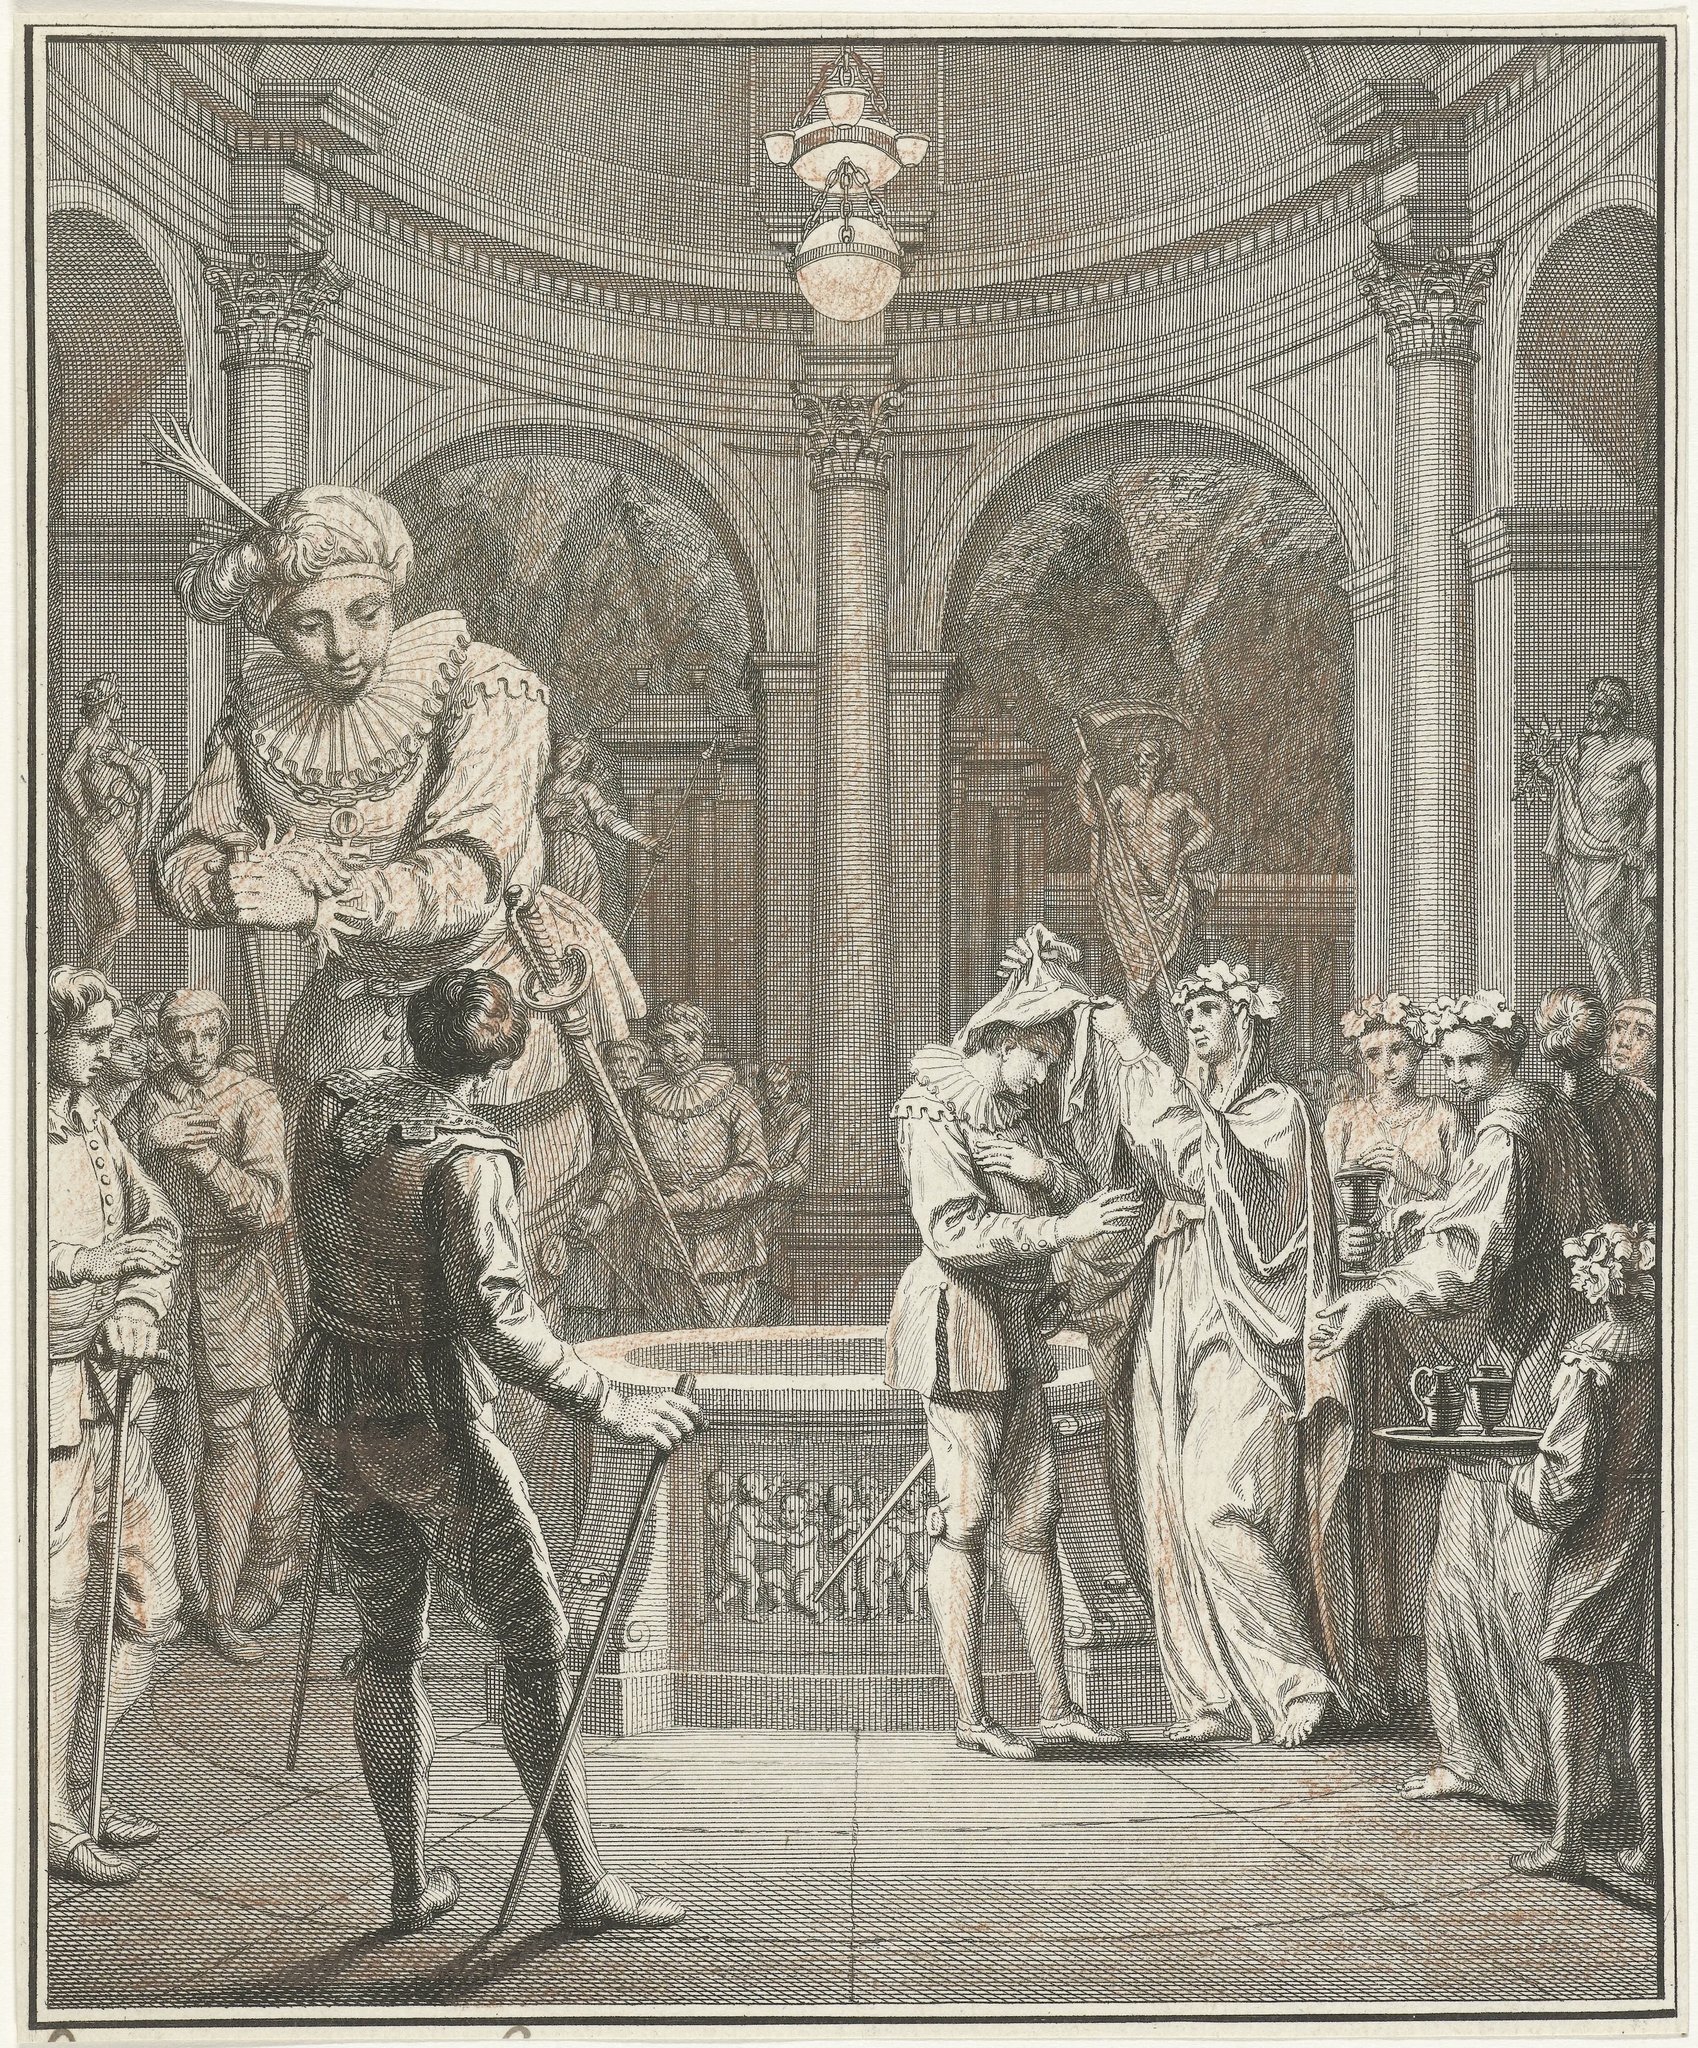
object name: print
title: Panurge en de hogepriesteres Bakbuk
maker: jacob folkema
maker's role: draughtsman, print maker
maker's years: 1692-1767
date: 1703-1767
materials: paper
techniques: etching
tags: giants, colossi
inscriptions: collector's mark: Lugt 240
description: In een tempel stelt Panurge, gesouffleerd door de hogepriesteres van de Fles Bakbuk, zijn rituele vraag: wat is het antwoord op mijn levensvraag, wat is waarheid, wat is wijsheid? Links aanschouwt op de achtergrond de reus Pantagruel samen met een groep figuren het ritueel.